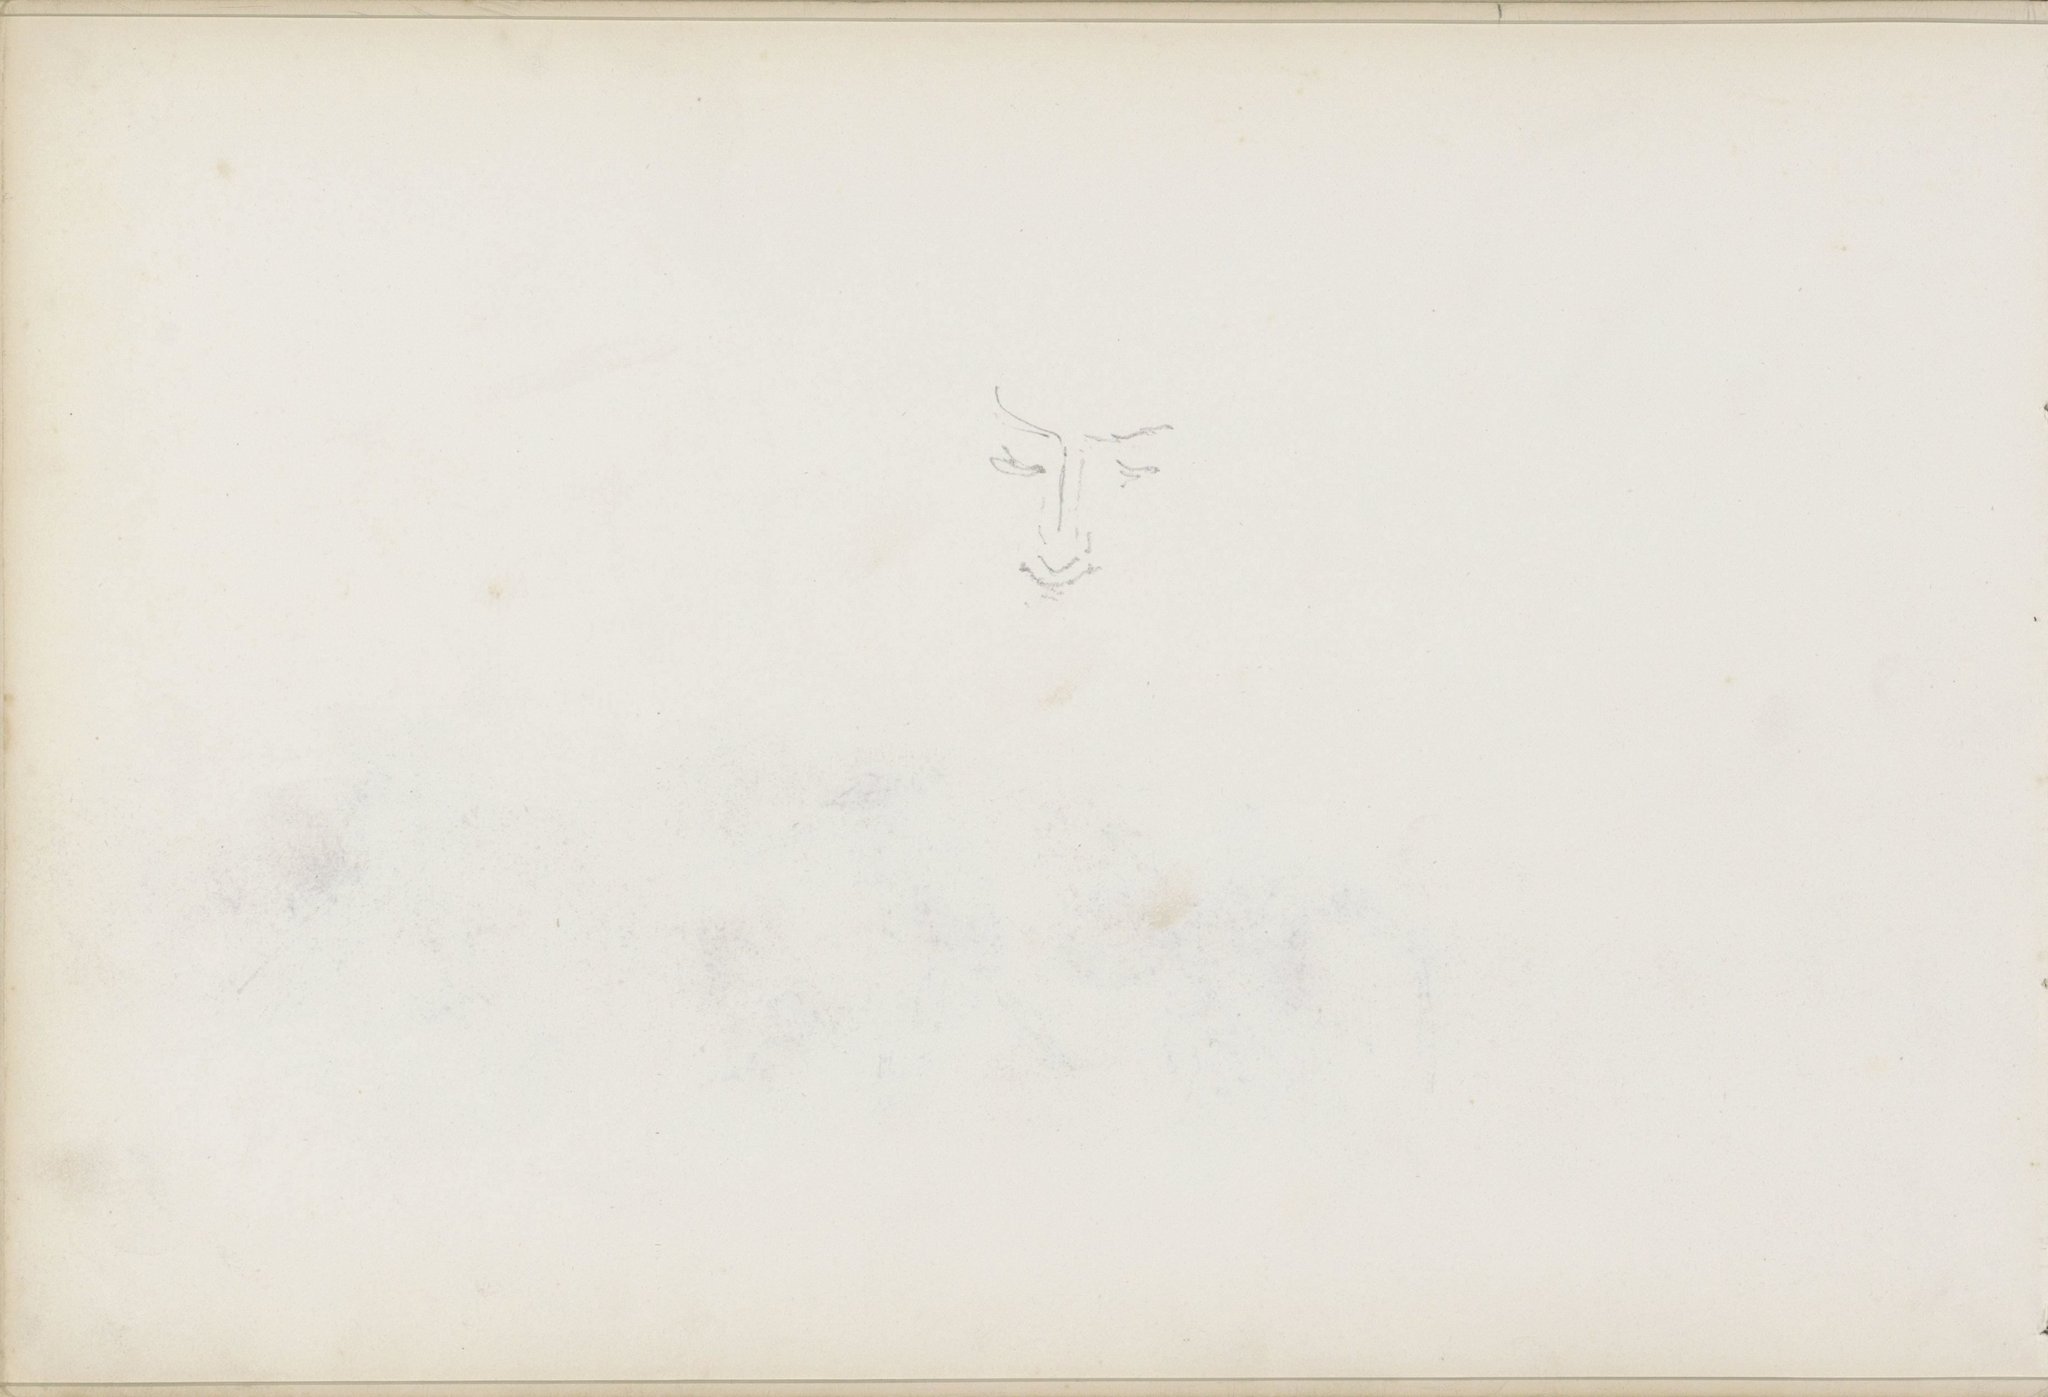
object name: sketchbook leaf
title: Gezicht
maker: george hendrik breitner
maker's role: draughtsman, painter, print maker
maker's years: 1857-1923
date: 1809-1872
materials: paper, pencil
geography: rotterdam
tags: face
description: Blad 38 verso uit een schetsboek met 32 bladen.